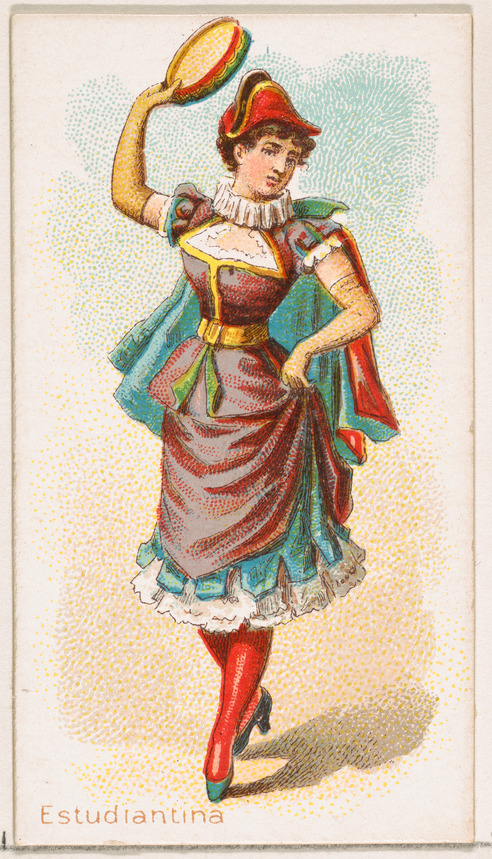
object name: print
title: Estudiantina Dancer, from the Dancing Women series (N186) issued by Wm. S. Kimball & Co.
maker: william s. kimball & company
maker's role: publisher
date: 1889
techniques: color lithograph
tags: women,dancers